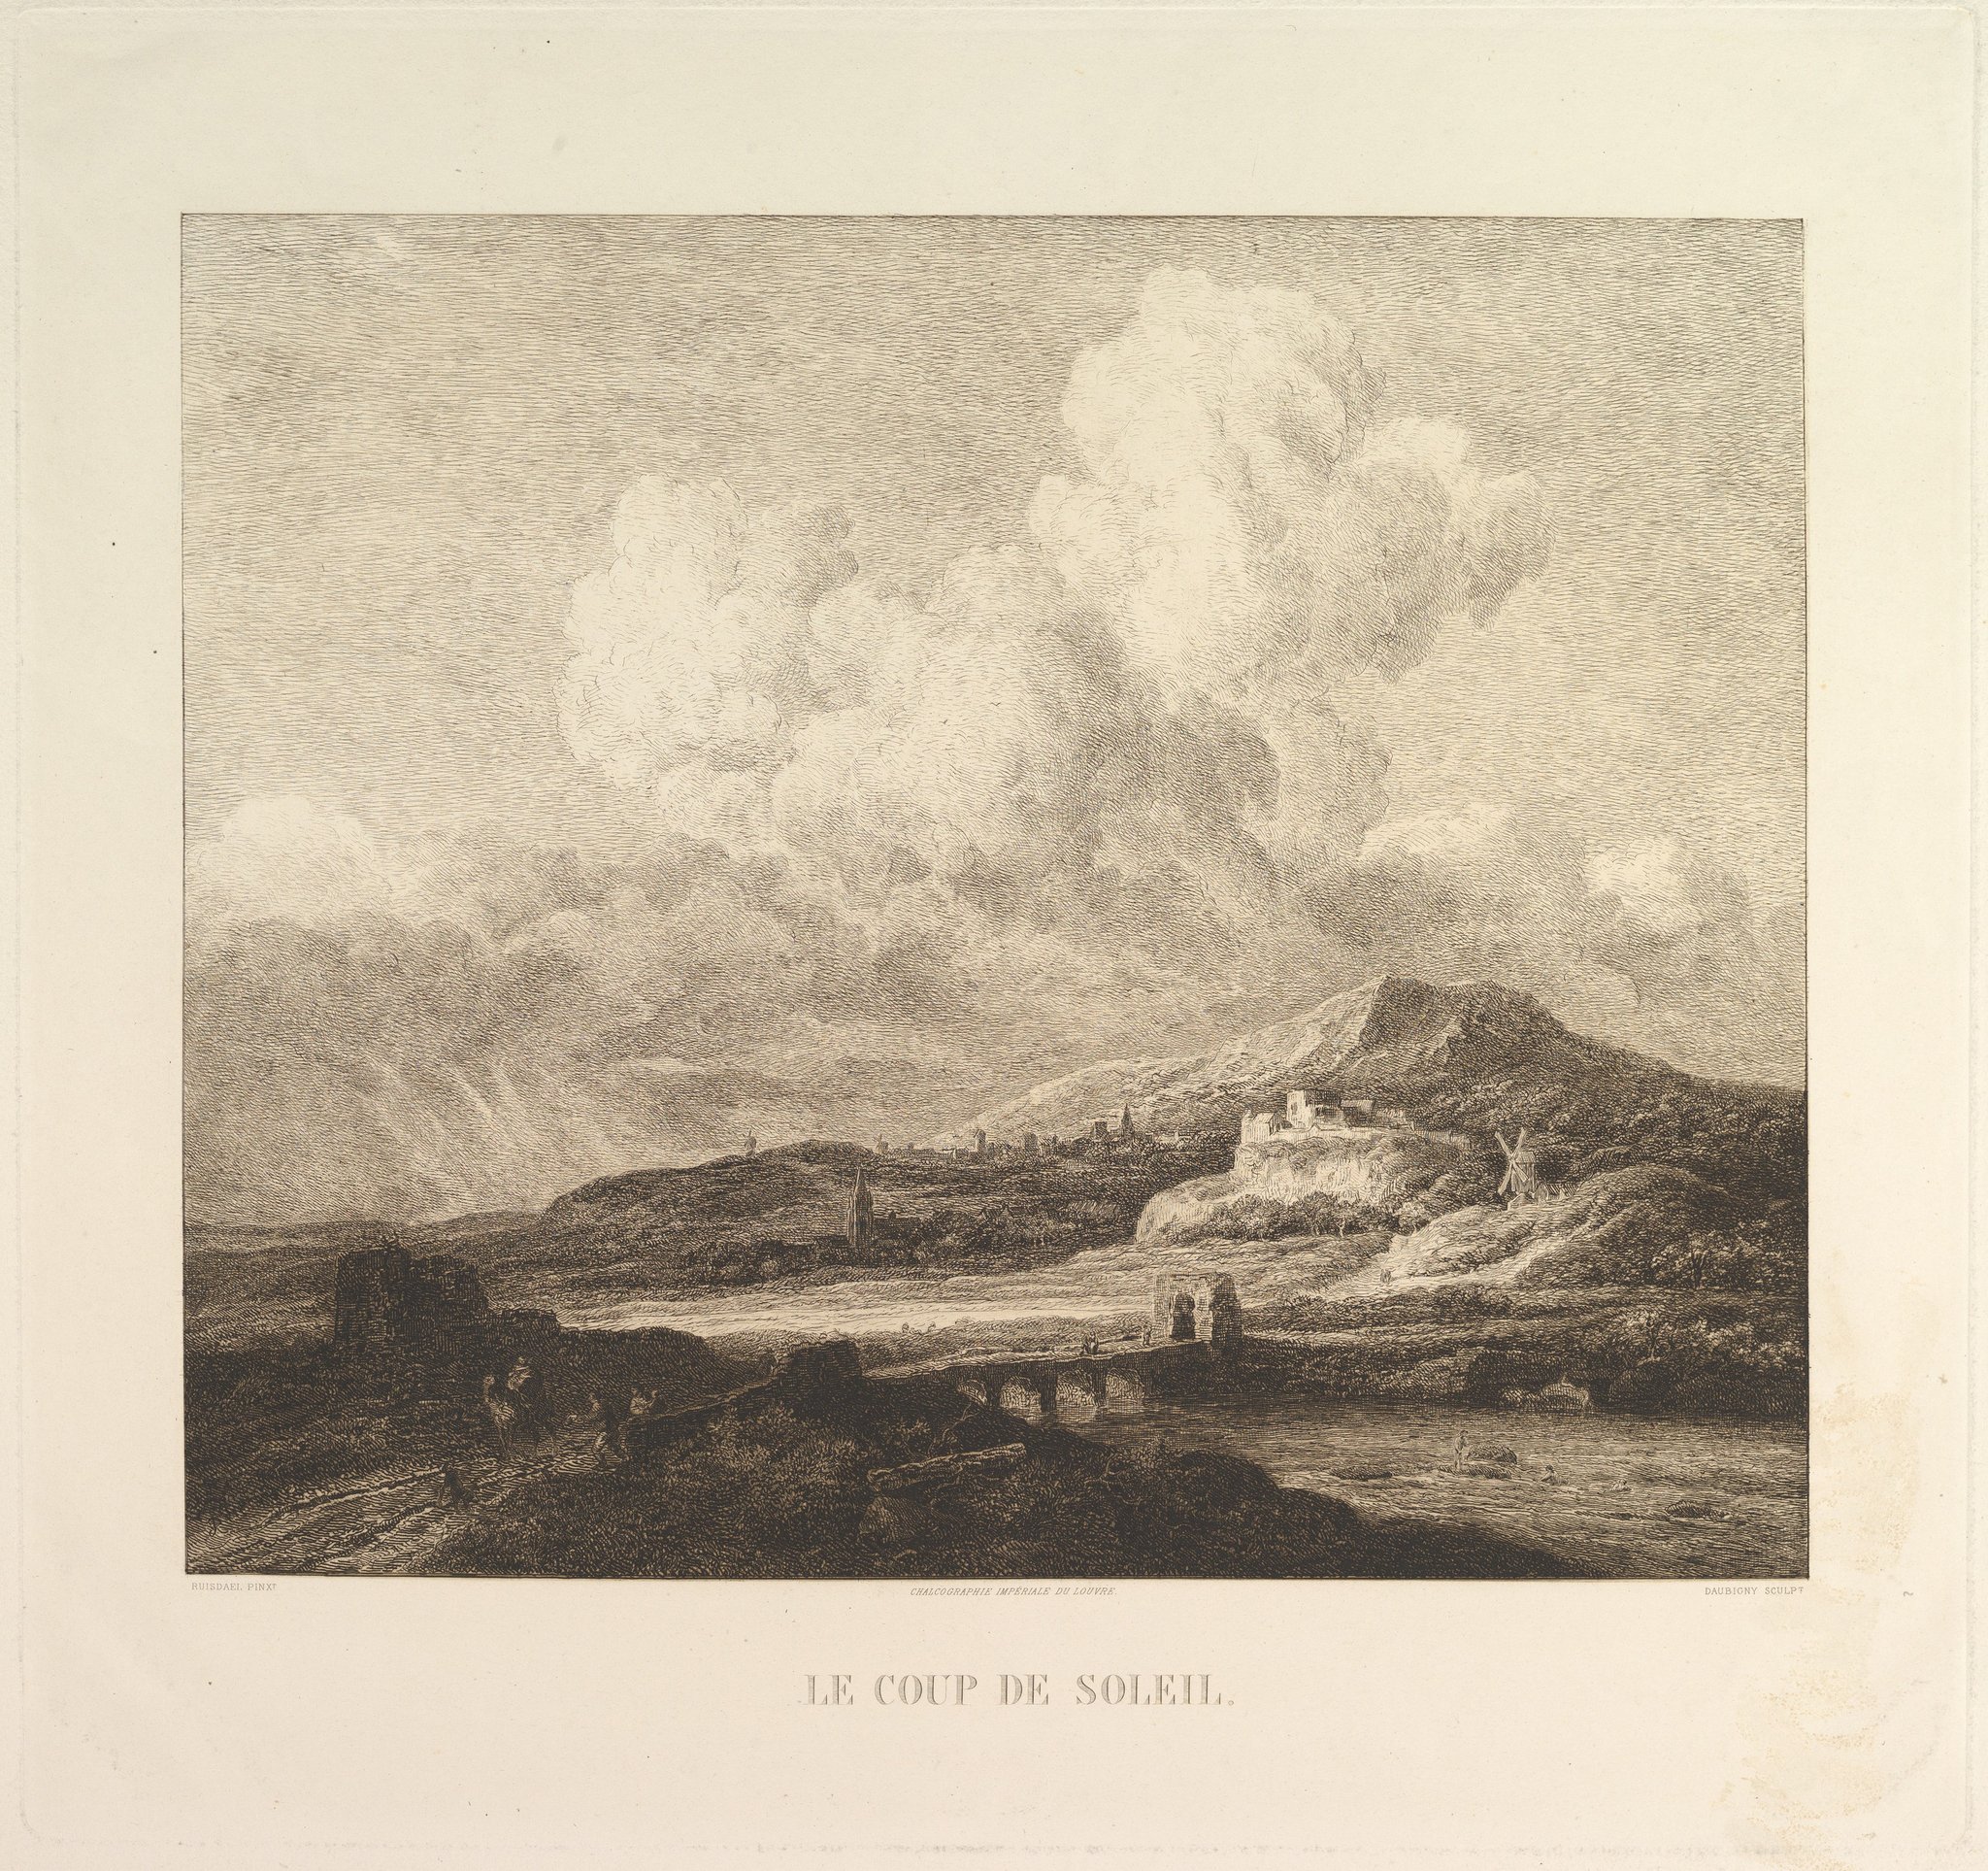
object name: print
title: A Burst of Sunlight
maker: charles-françois daubigny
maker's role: artist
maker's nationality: french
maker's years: 1817-1878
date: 1860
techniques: etching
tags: bridges,landscapes,clouds